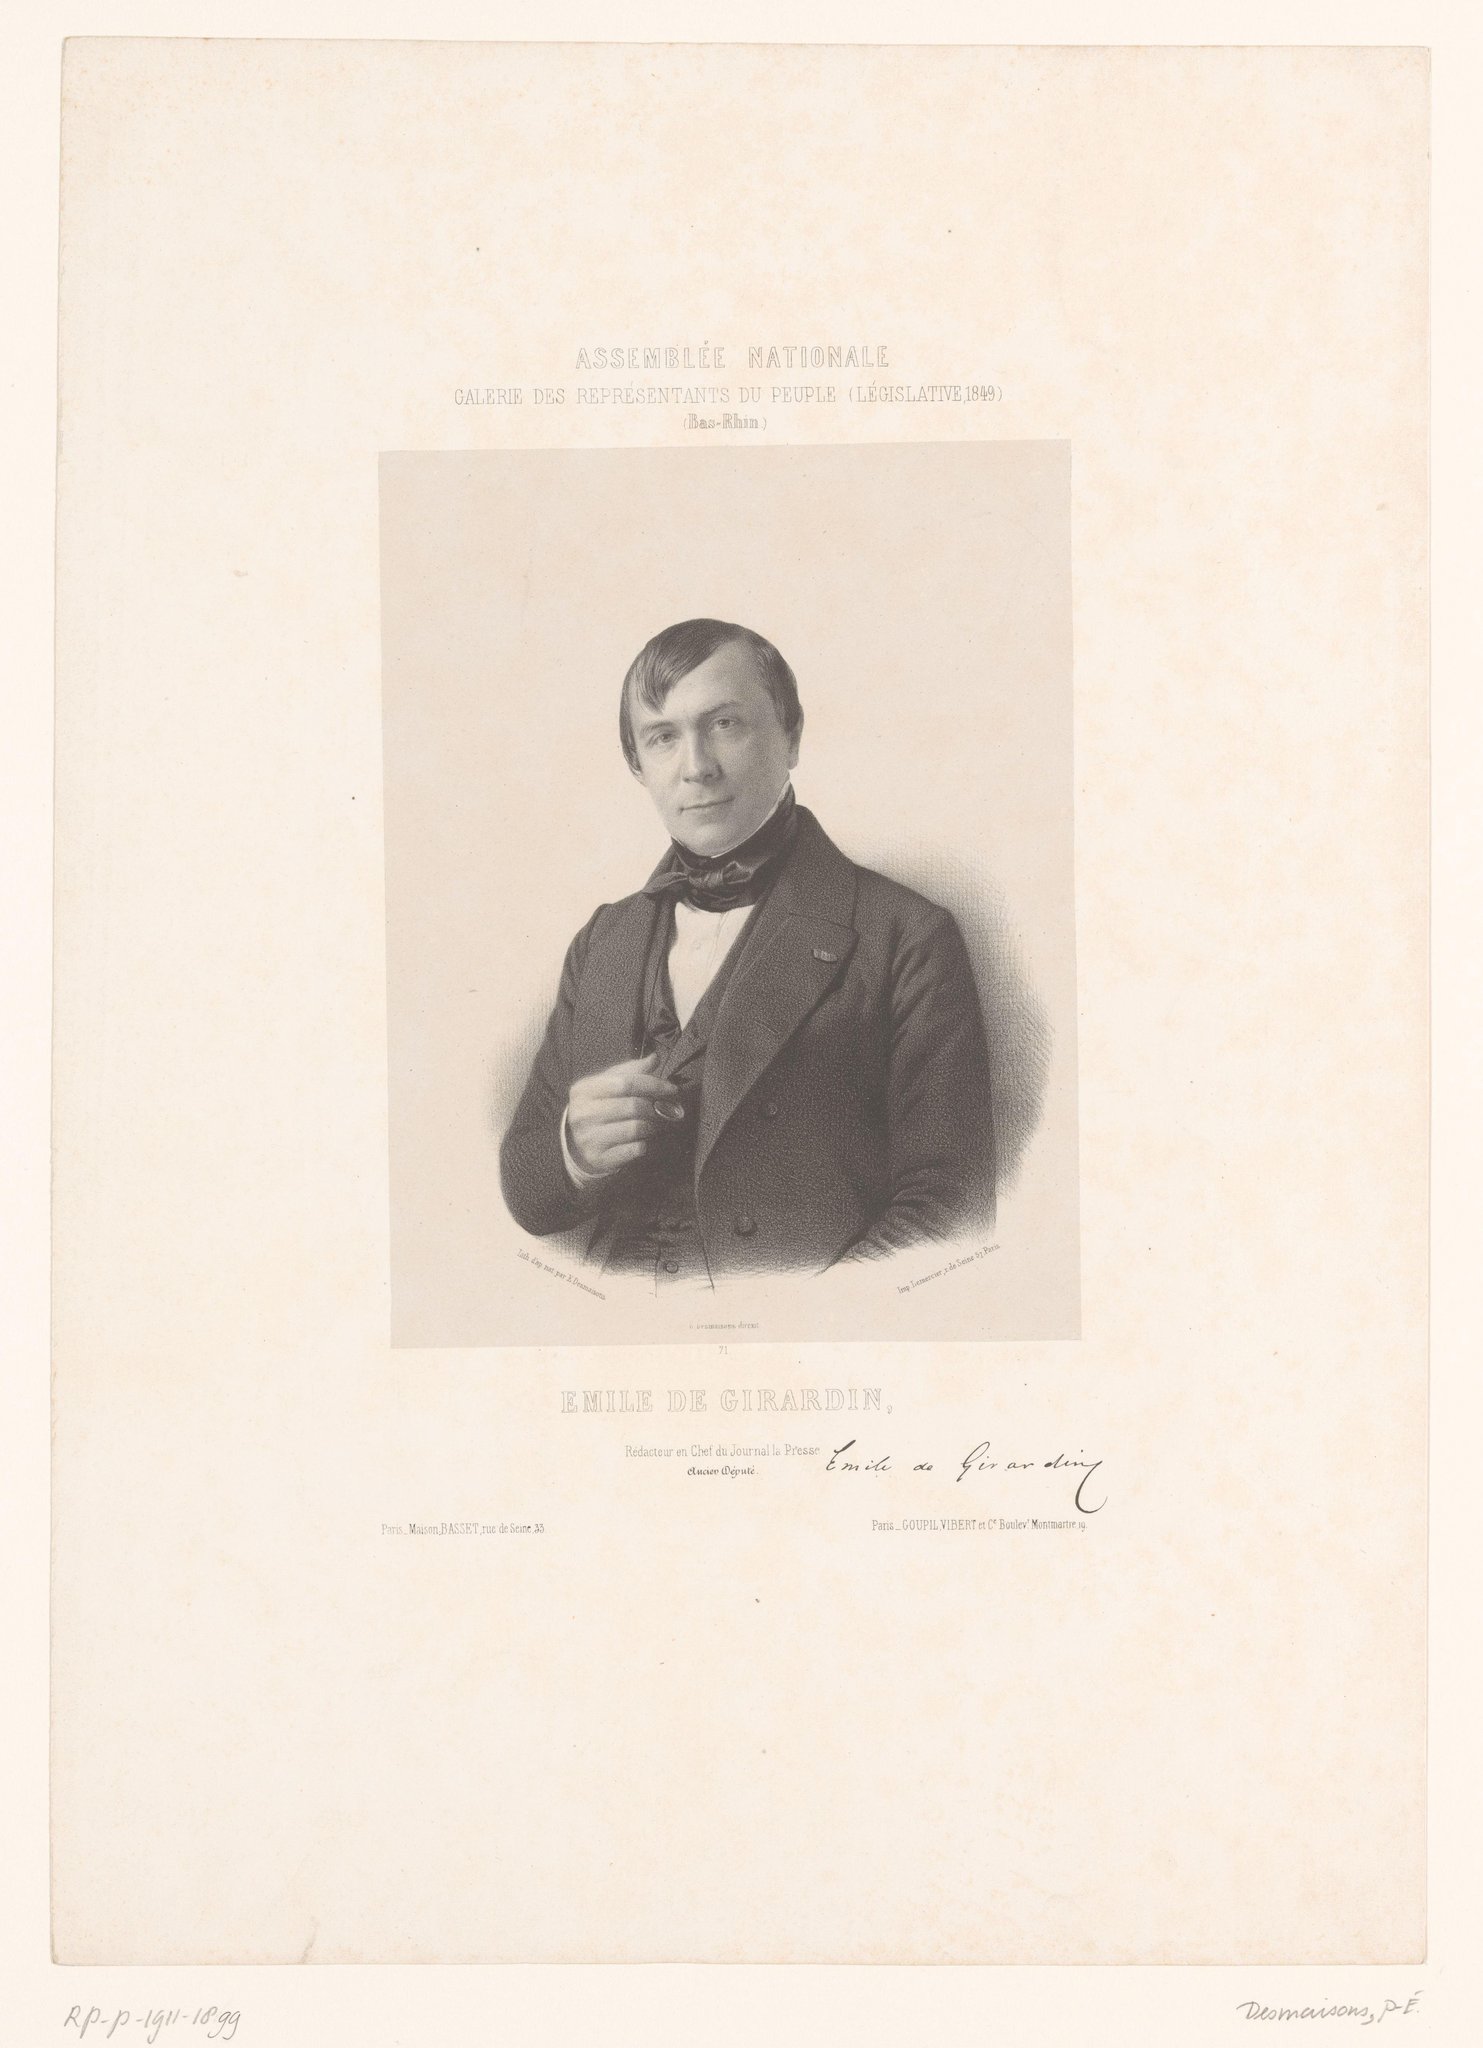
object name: print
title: Emile de Girardin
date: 1848-1849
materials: paper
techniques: lithograph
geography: paris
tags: paris, politician, publisher, émile de girardin, historical persons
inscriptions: collector's mark: Lugt 2228a